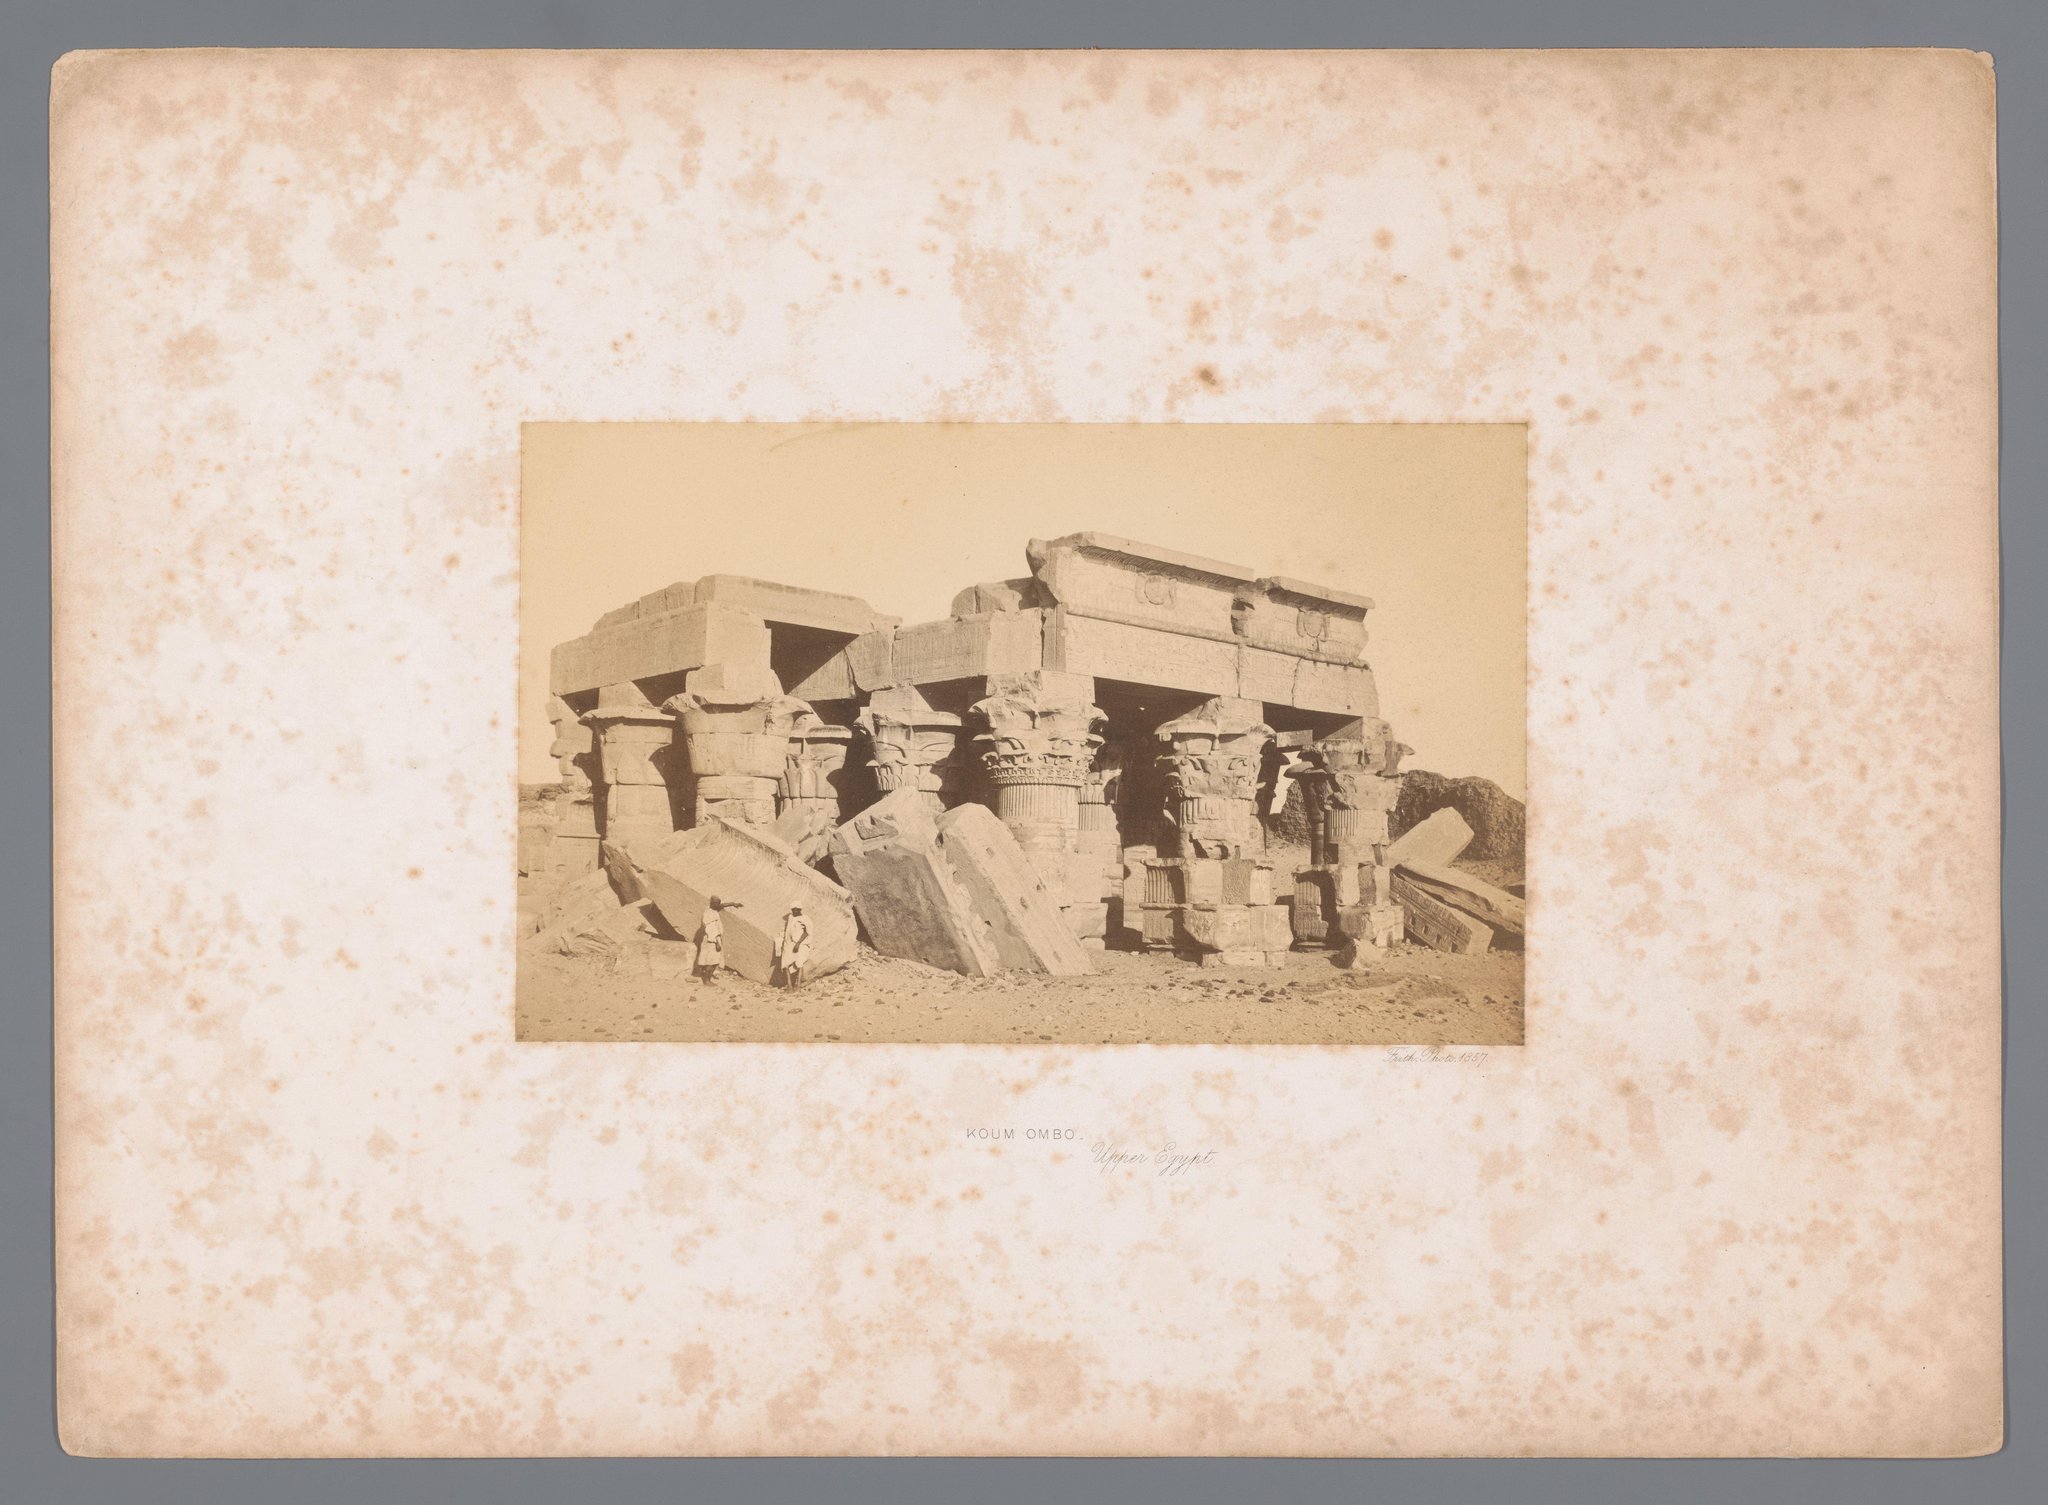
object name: page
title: Koum Ombo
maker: francis frith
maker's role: publisher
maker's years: 1822-1898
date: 1857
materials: paper, photographic support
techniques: albumen print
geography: kom ombo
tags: francis frith, temple, shrine ~ egyptian religion, ruin of a building ~ architecture, historical persons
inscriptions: inscription: ‘Upper Egypt’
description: Deze foto maakt deel uit van een omslag met 7 bladen met albuminedrukken.